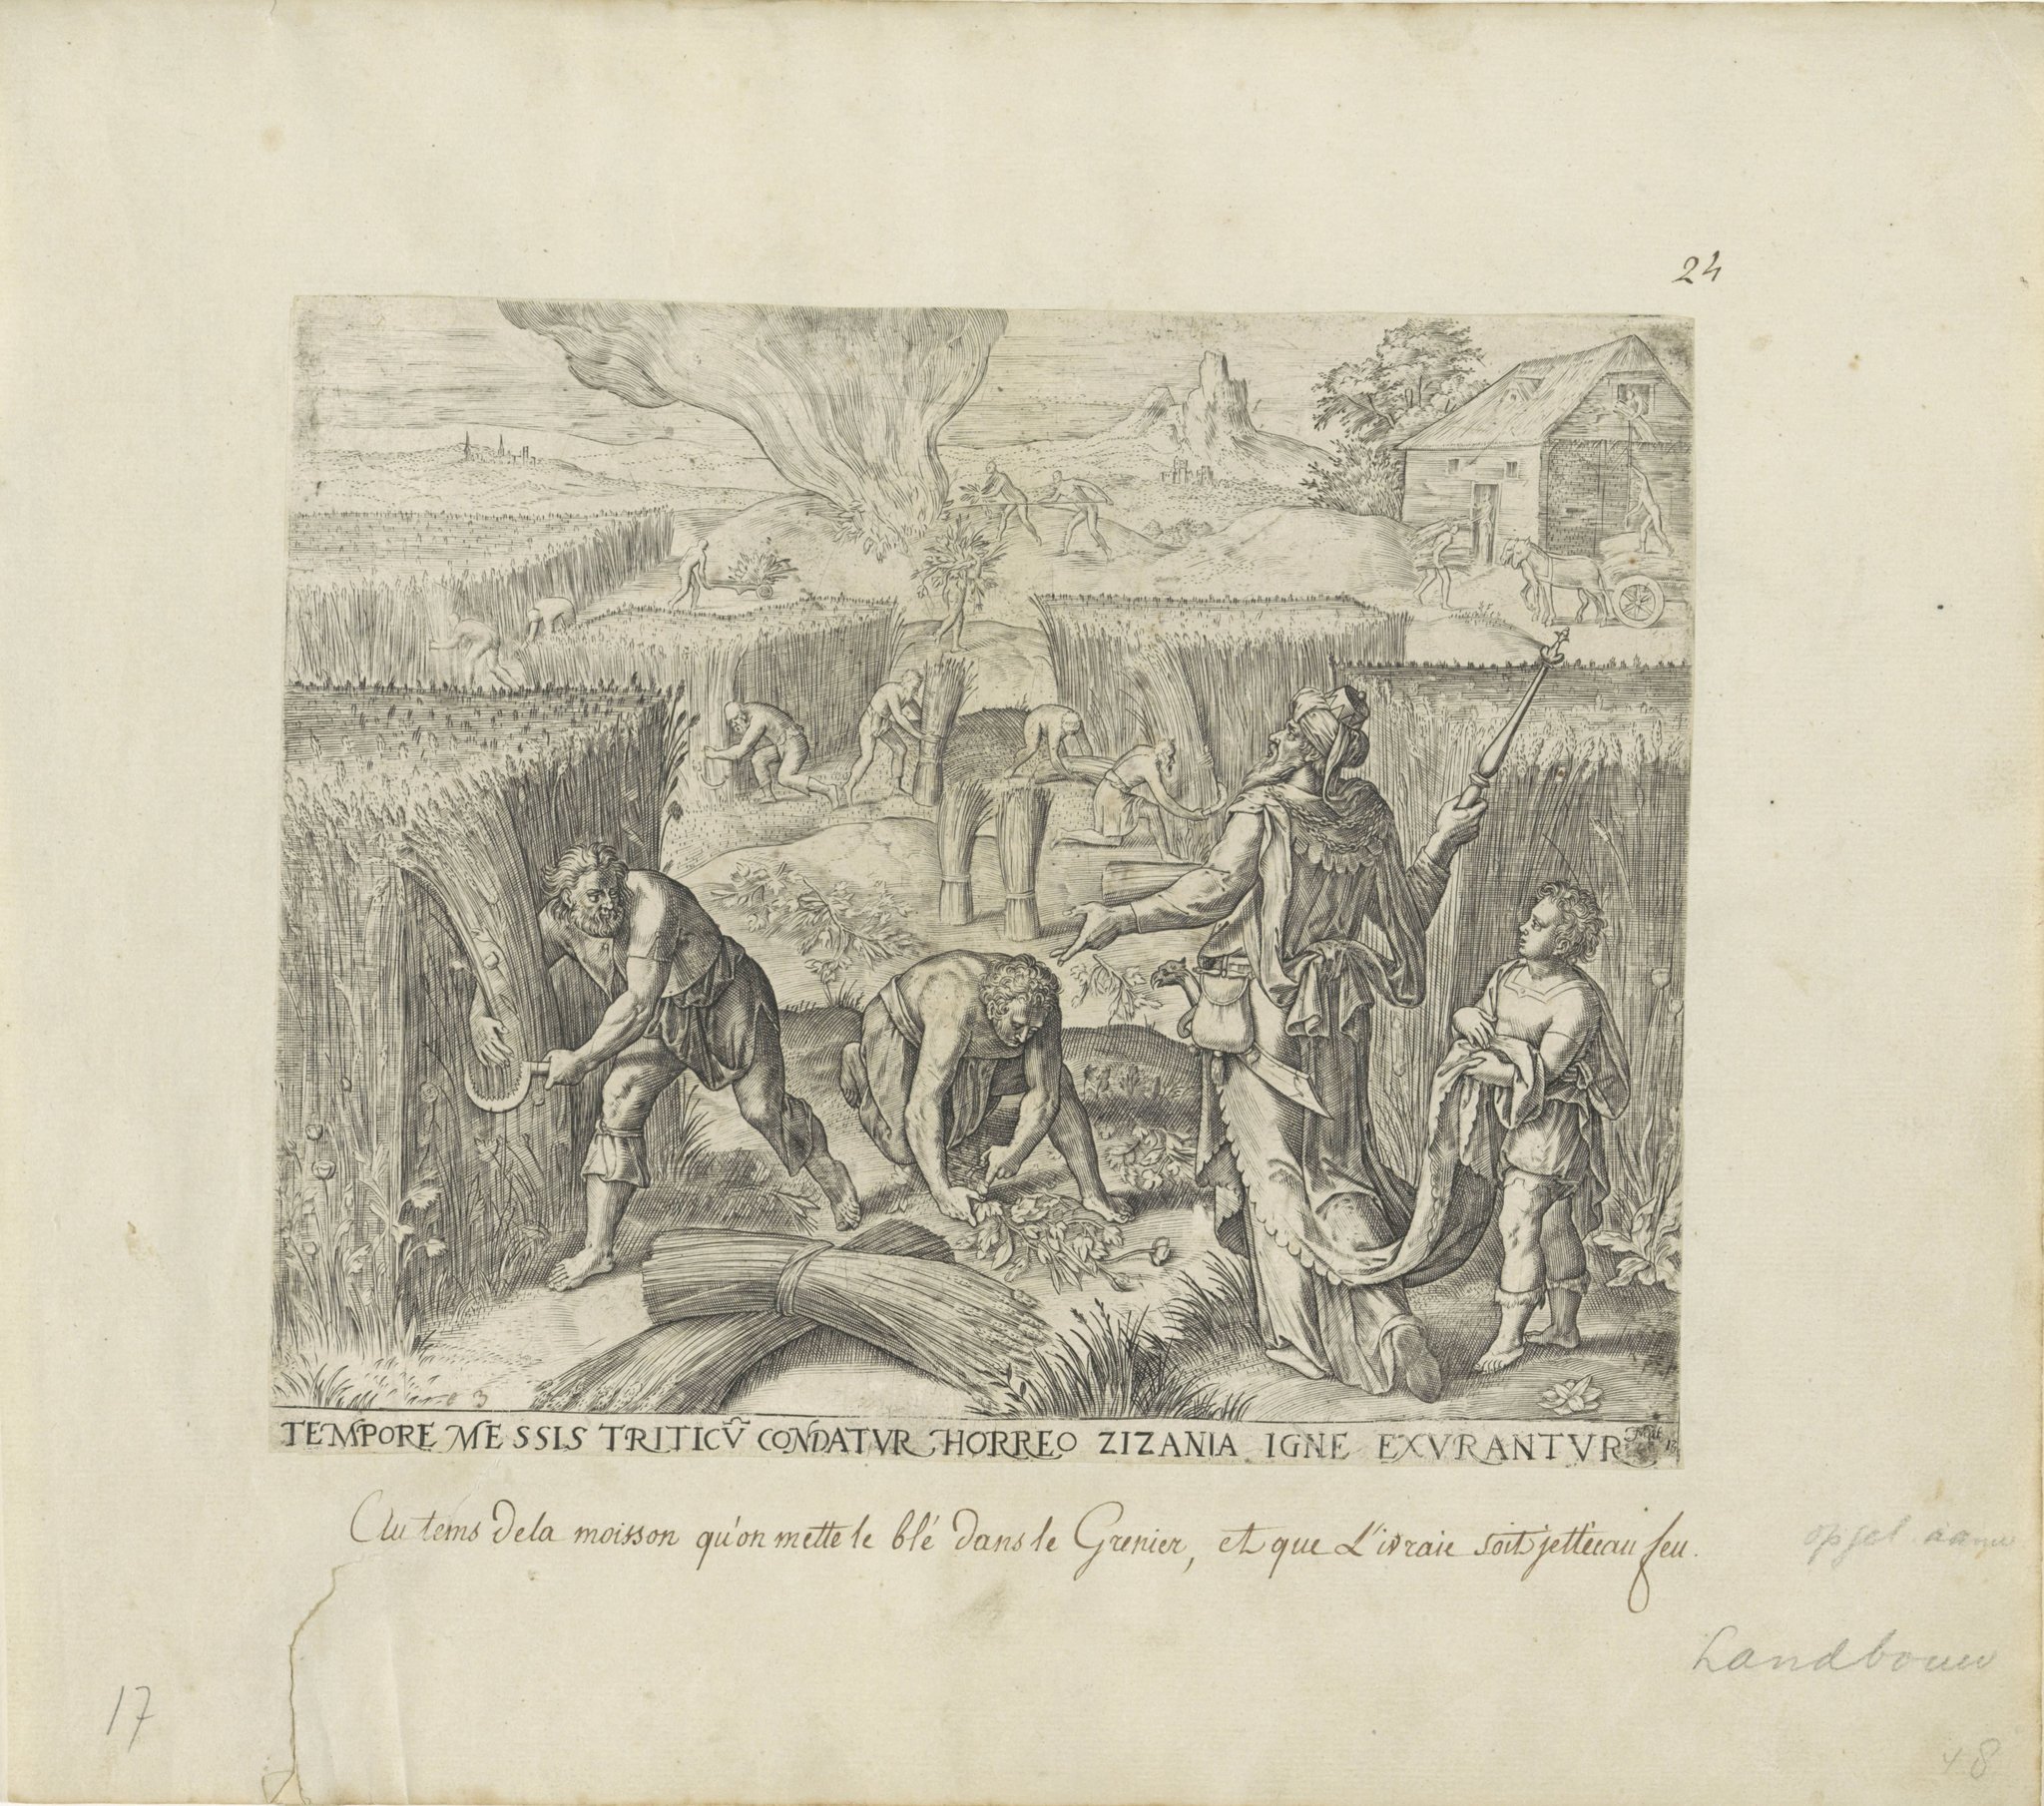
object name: print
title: Thesaurus sacrarum historiarum veteris testamenti (...)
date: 1579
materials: paper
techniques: engraving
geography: antwerp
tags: in time of the harvest the tares are bound and burned, but the wheat is gathered and put in the barn of the lord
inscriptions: collector's mark: Lugt 2228, inscription: ‘Ou tems dela moisson qu'on mette le blé dans le Grenier, et que l'ivraie soit jettèe au feu.’, number: ‘24’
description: De landheer, met een scepter in de hand, geeft de opdracht om de oogst binnen te halen. Het graan wordt geoogst en het onkruid wordt verzameld en verbrand. Een jongen houdt het kleed van de landheer vast. Onder de voorstelling een verwijzing in het Latijn naar de Bijbeltekst in Mat. 13.